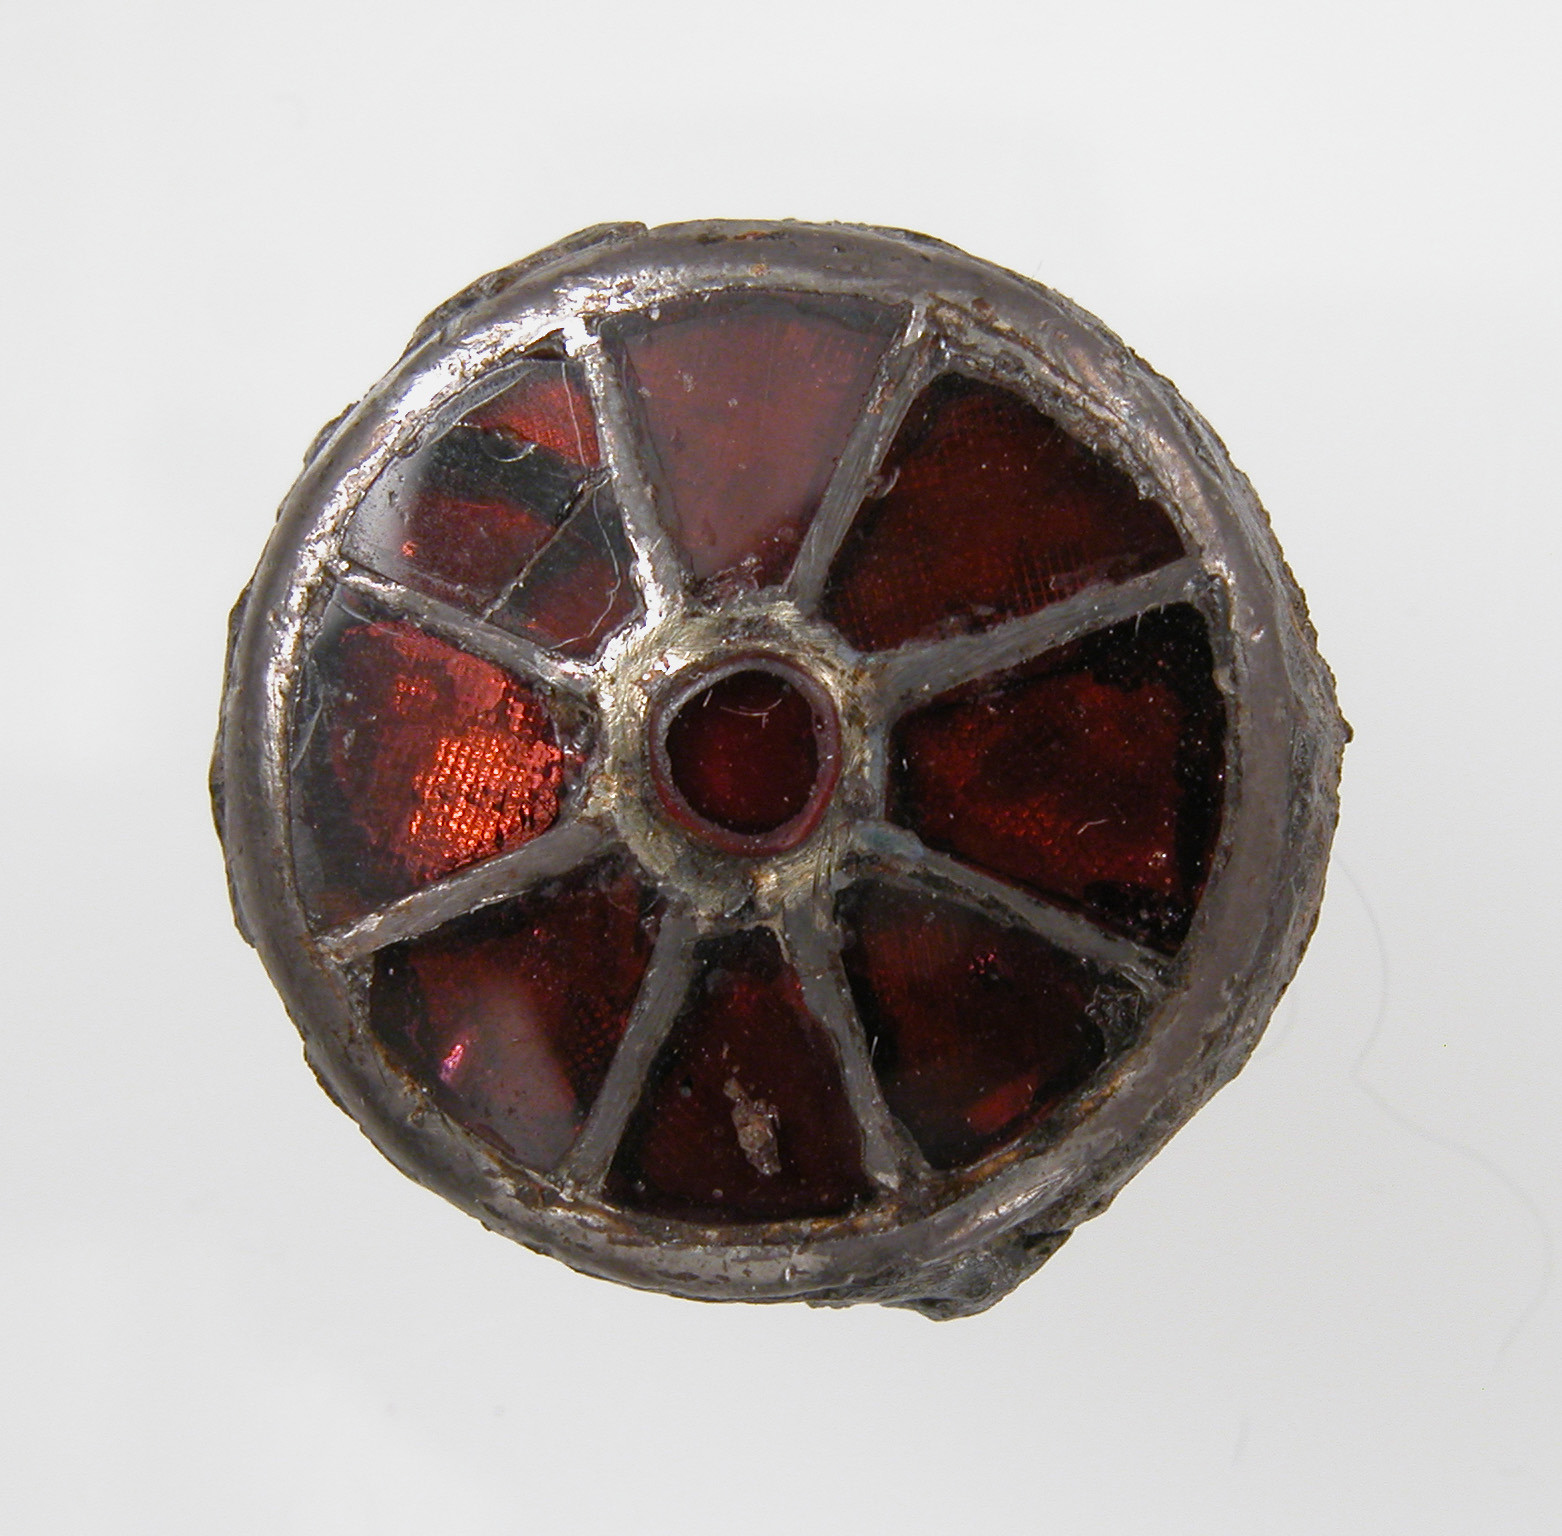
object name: brooch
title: Disk Brooch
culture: frankish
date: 501-600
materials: gemstone, glass, gold foil, iron, paste, silver